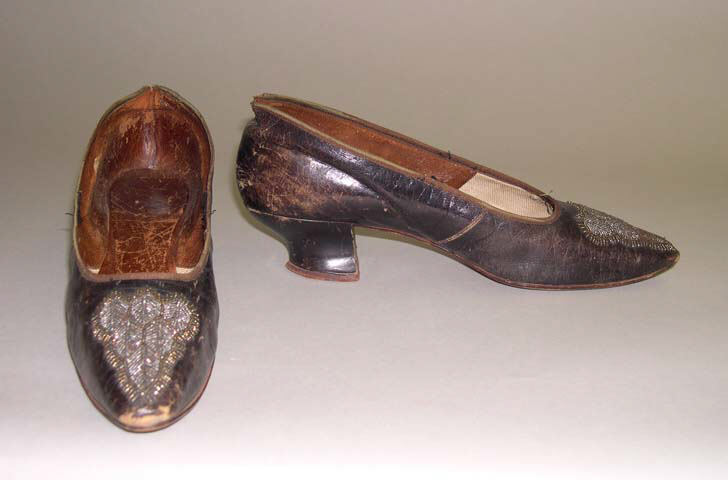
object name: pump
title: Pumps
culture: american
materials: leather